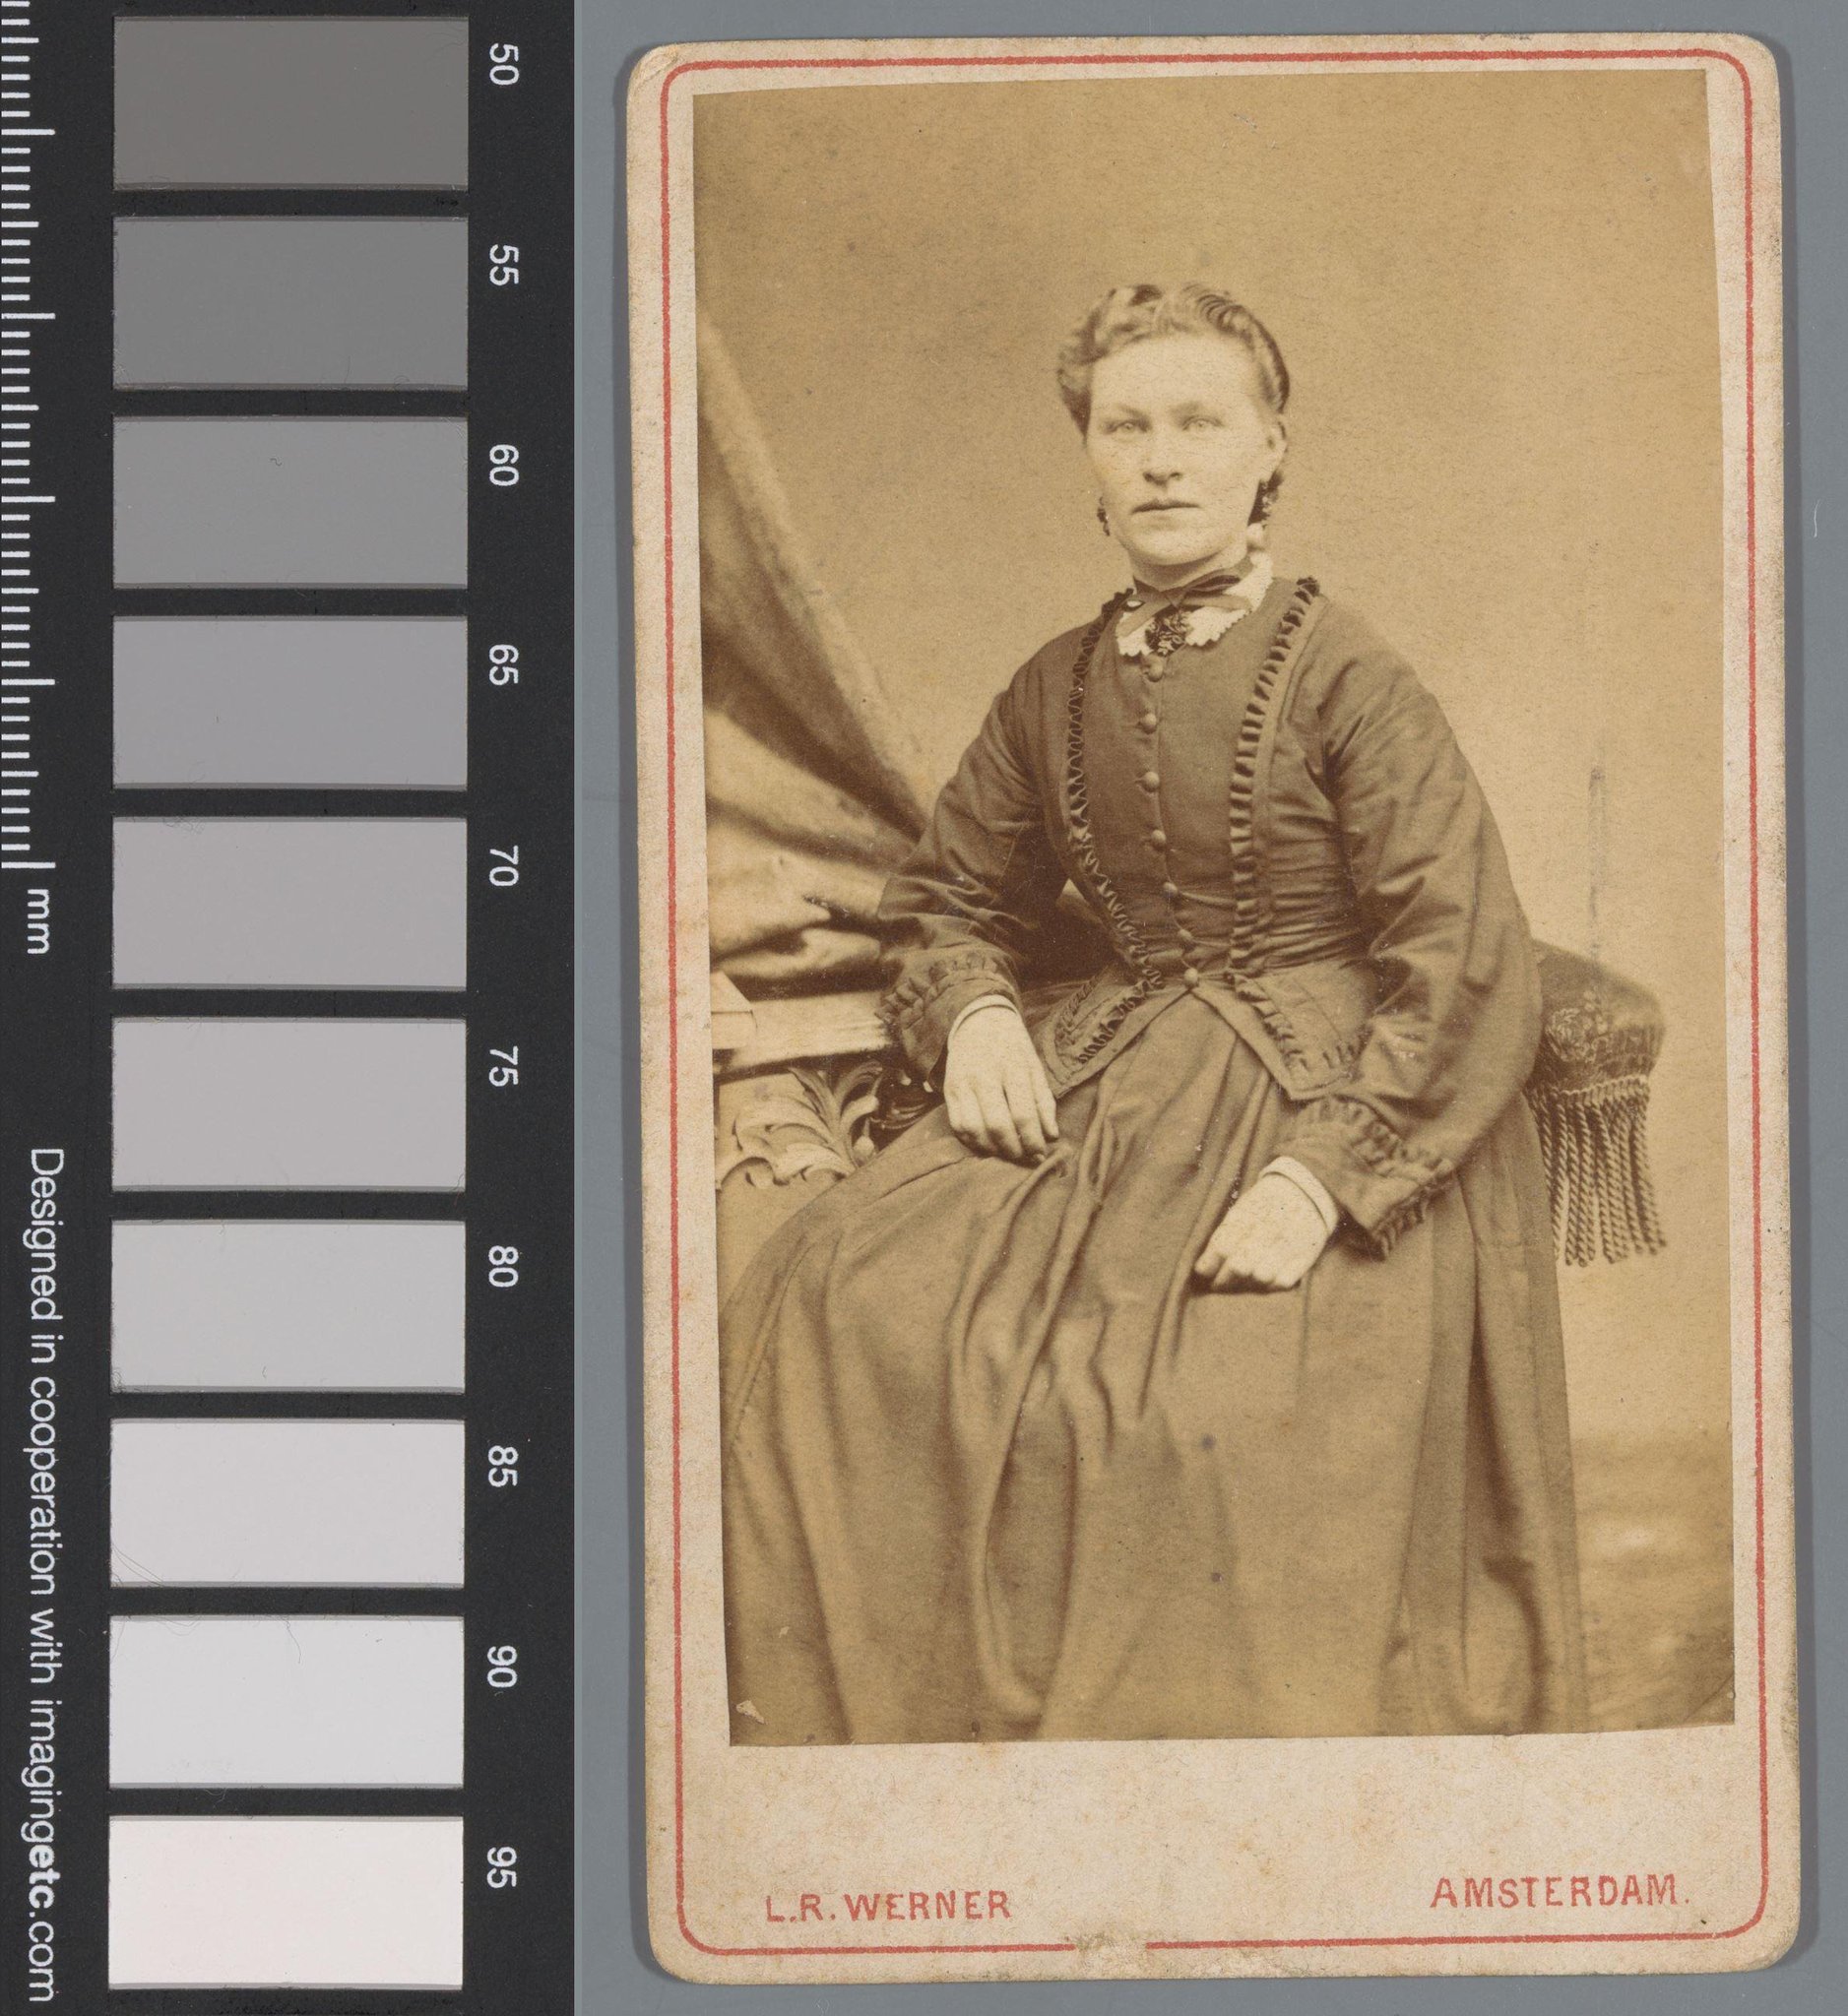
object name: photograph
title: Portret van een onbekende vrouw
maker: louis robert werner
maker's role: fotograaf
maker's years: 1834-1896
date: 1871-1877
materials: cardboard, paper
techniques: albumen print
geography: amsterdam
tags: adult woman, anonymous historical person portrayed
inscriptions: address: ‘Nieuwendyk H. 201/ Amsterdam.’, inscription: ‘voorheen/ P. CARSTENSEN/ Voor nabestellingen blijft de Plaat bewaard.’, number: ‘3’